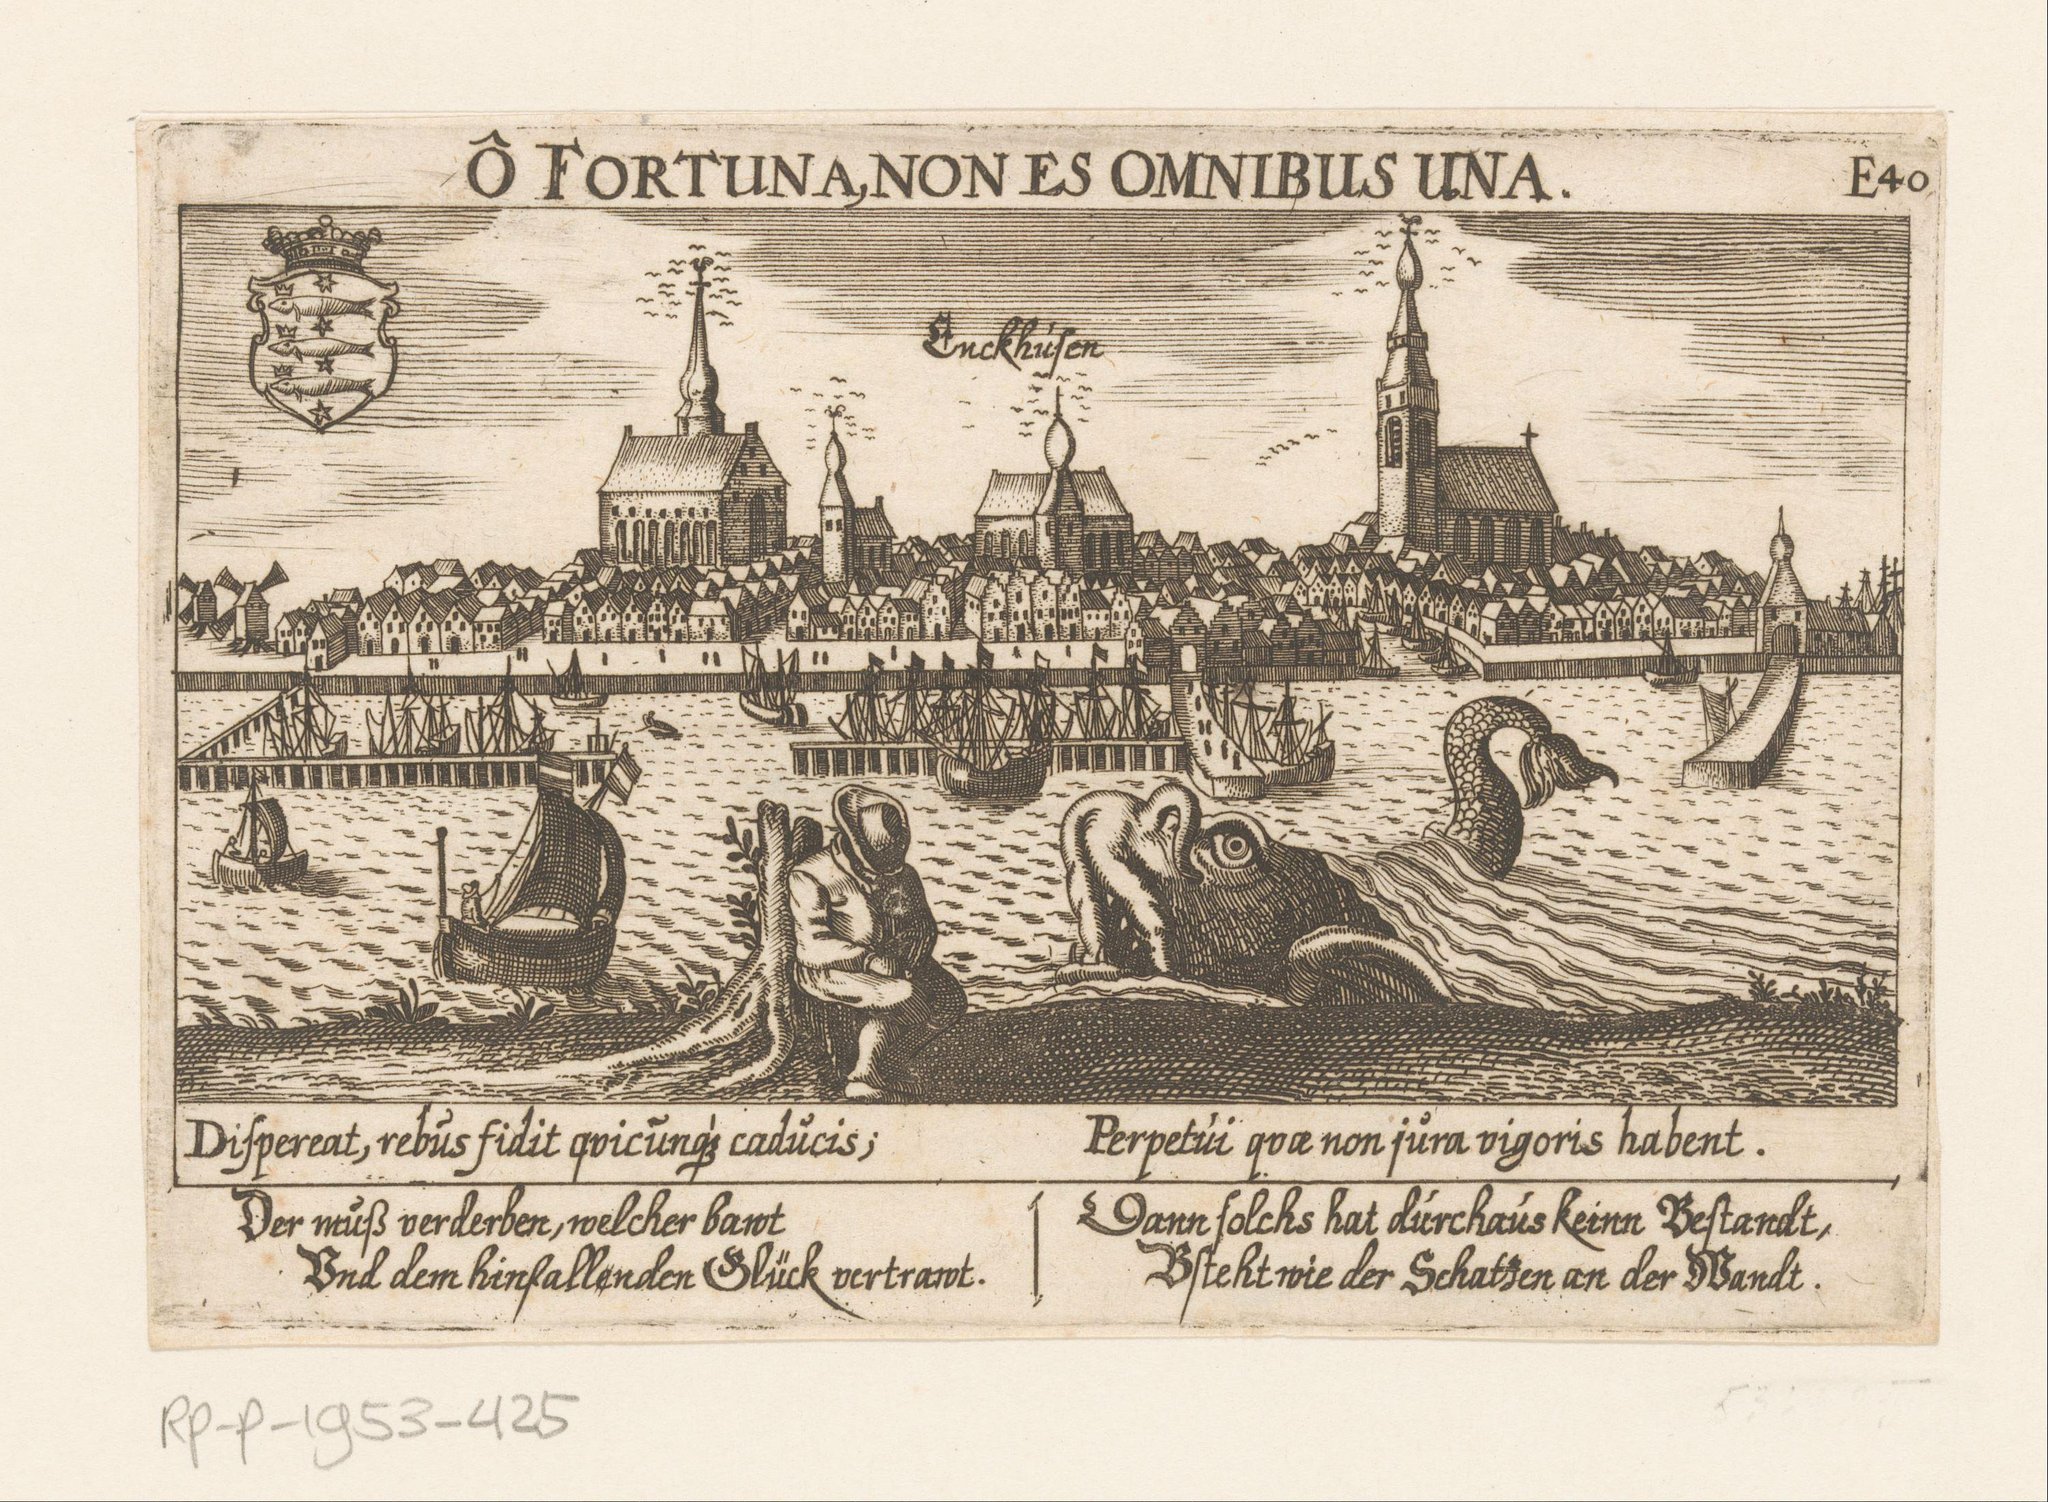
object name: print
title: Wereldwijde stadsgezichten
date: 1637-1638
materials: paper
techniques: etching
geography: nuremberg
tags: harbour, coat of arms (as symbol of the state, etc.), city-view, and landscape with man-made constructions, enkhuizen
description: Rechtsboven genummerd: E40. Bovenin staat het Latijnse motto 'O fortuna, non es omnibus una'. Onder de prent twee emblematische verzen: twee regels in het Latijn en vier regels in het Duits.